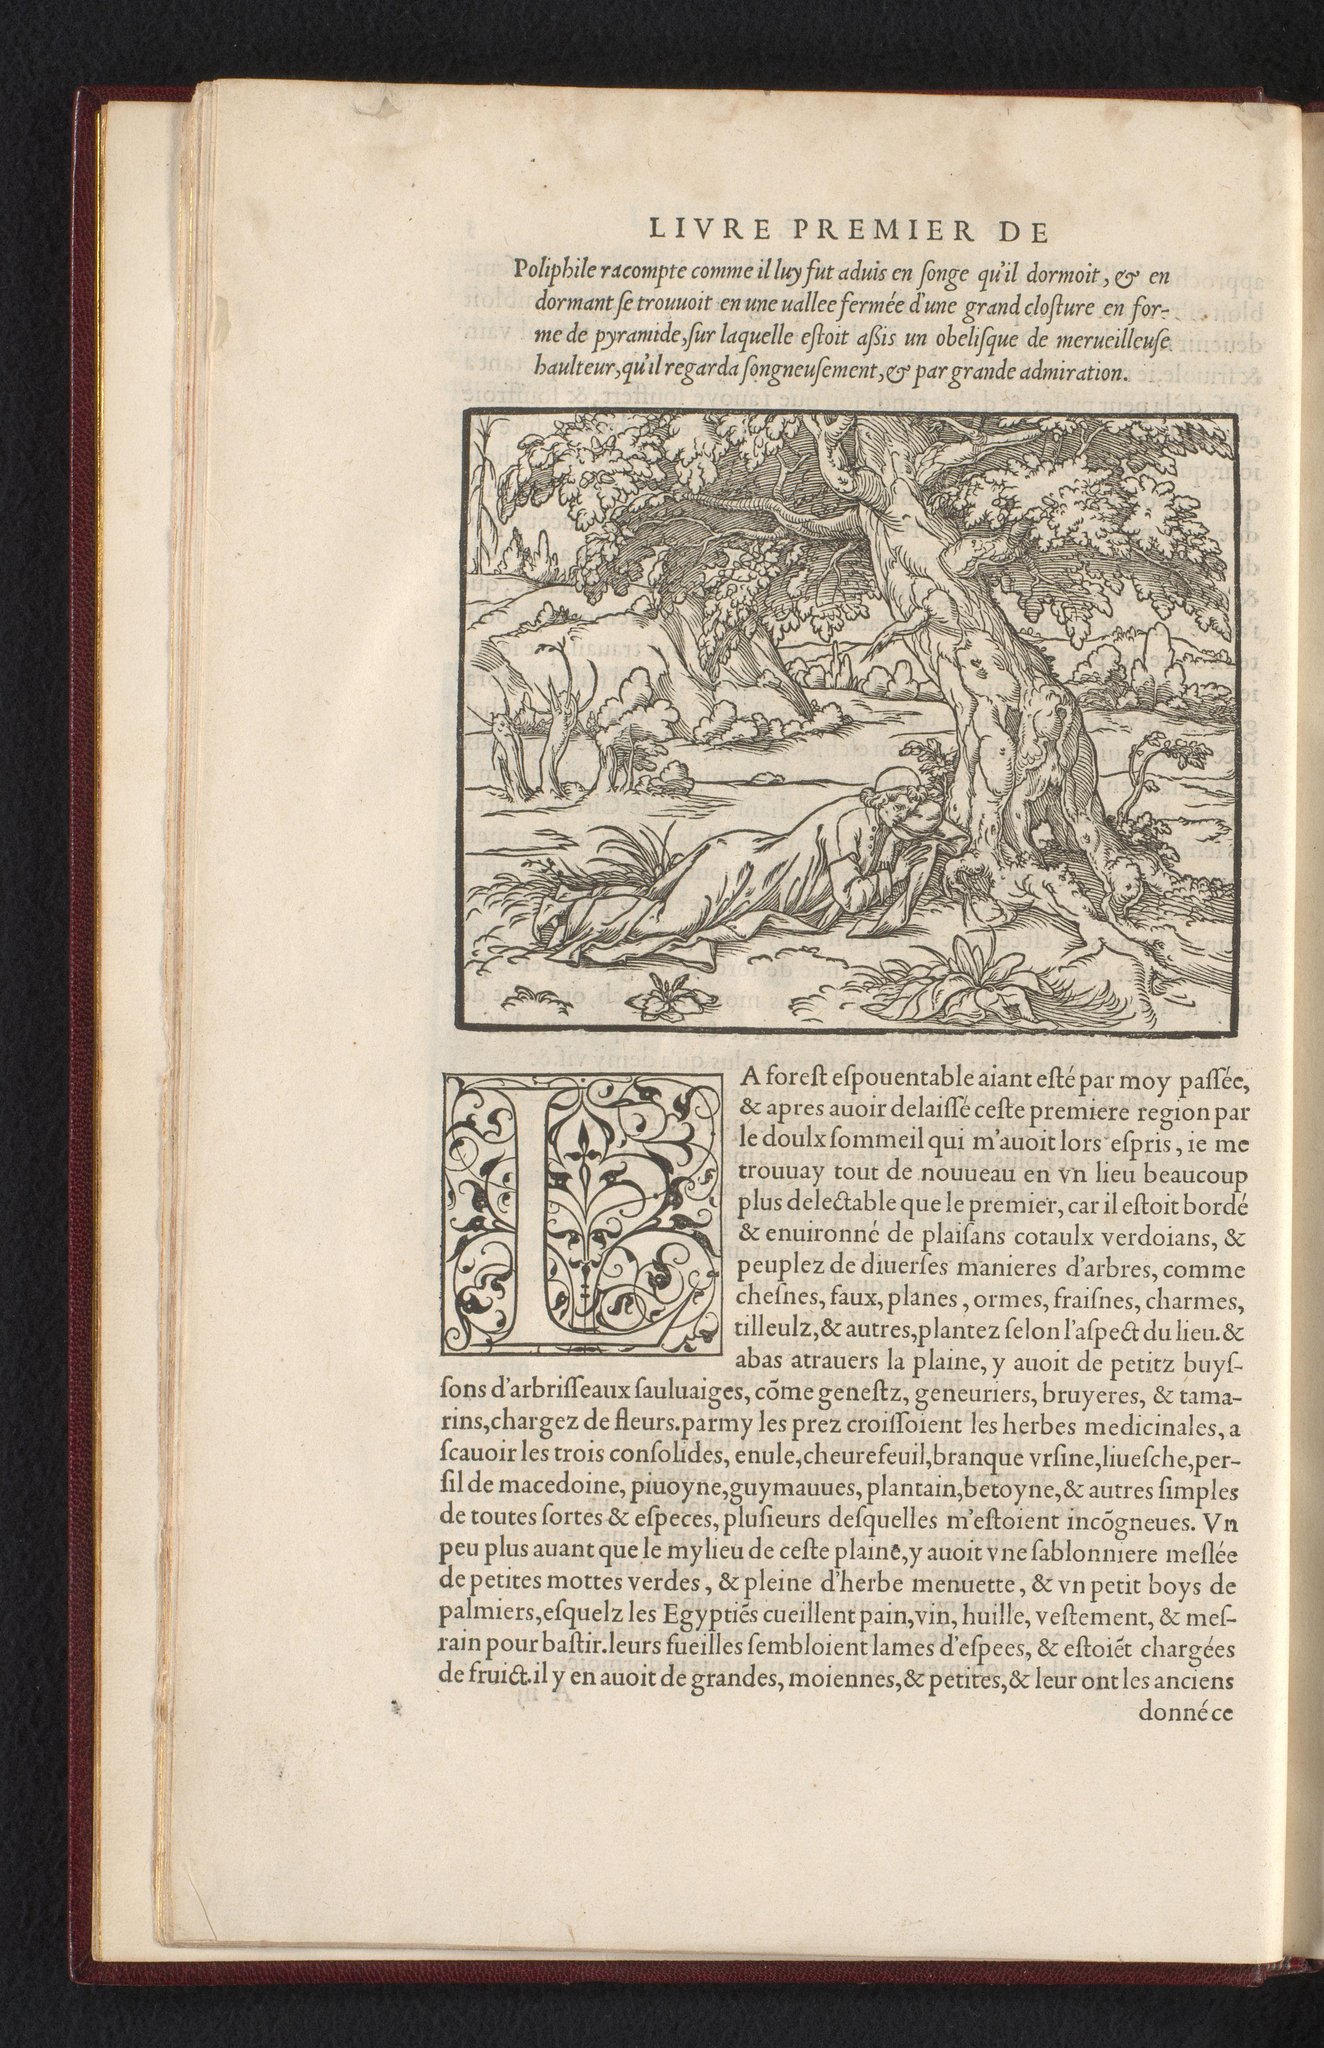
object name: print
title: Poliphilo valt in slaap en droomt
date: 1546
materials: paper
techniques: letterpress printing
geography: paris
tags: (scenes from) specific works of literature: colonna, hypnerotomachia poliphili, sleeping on the ground, dream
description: Prent uit: Colonna, Francesco. Hypnerotomachie ou discours du songe de Poliphile, deduisant comme amour le combat a l'occasion de Polia. Parijs: Jacques Kerver, 1546, verso fol. 3.